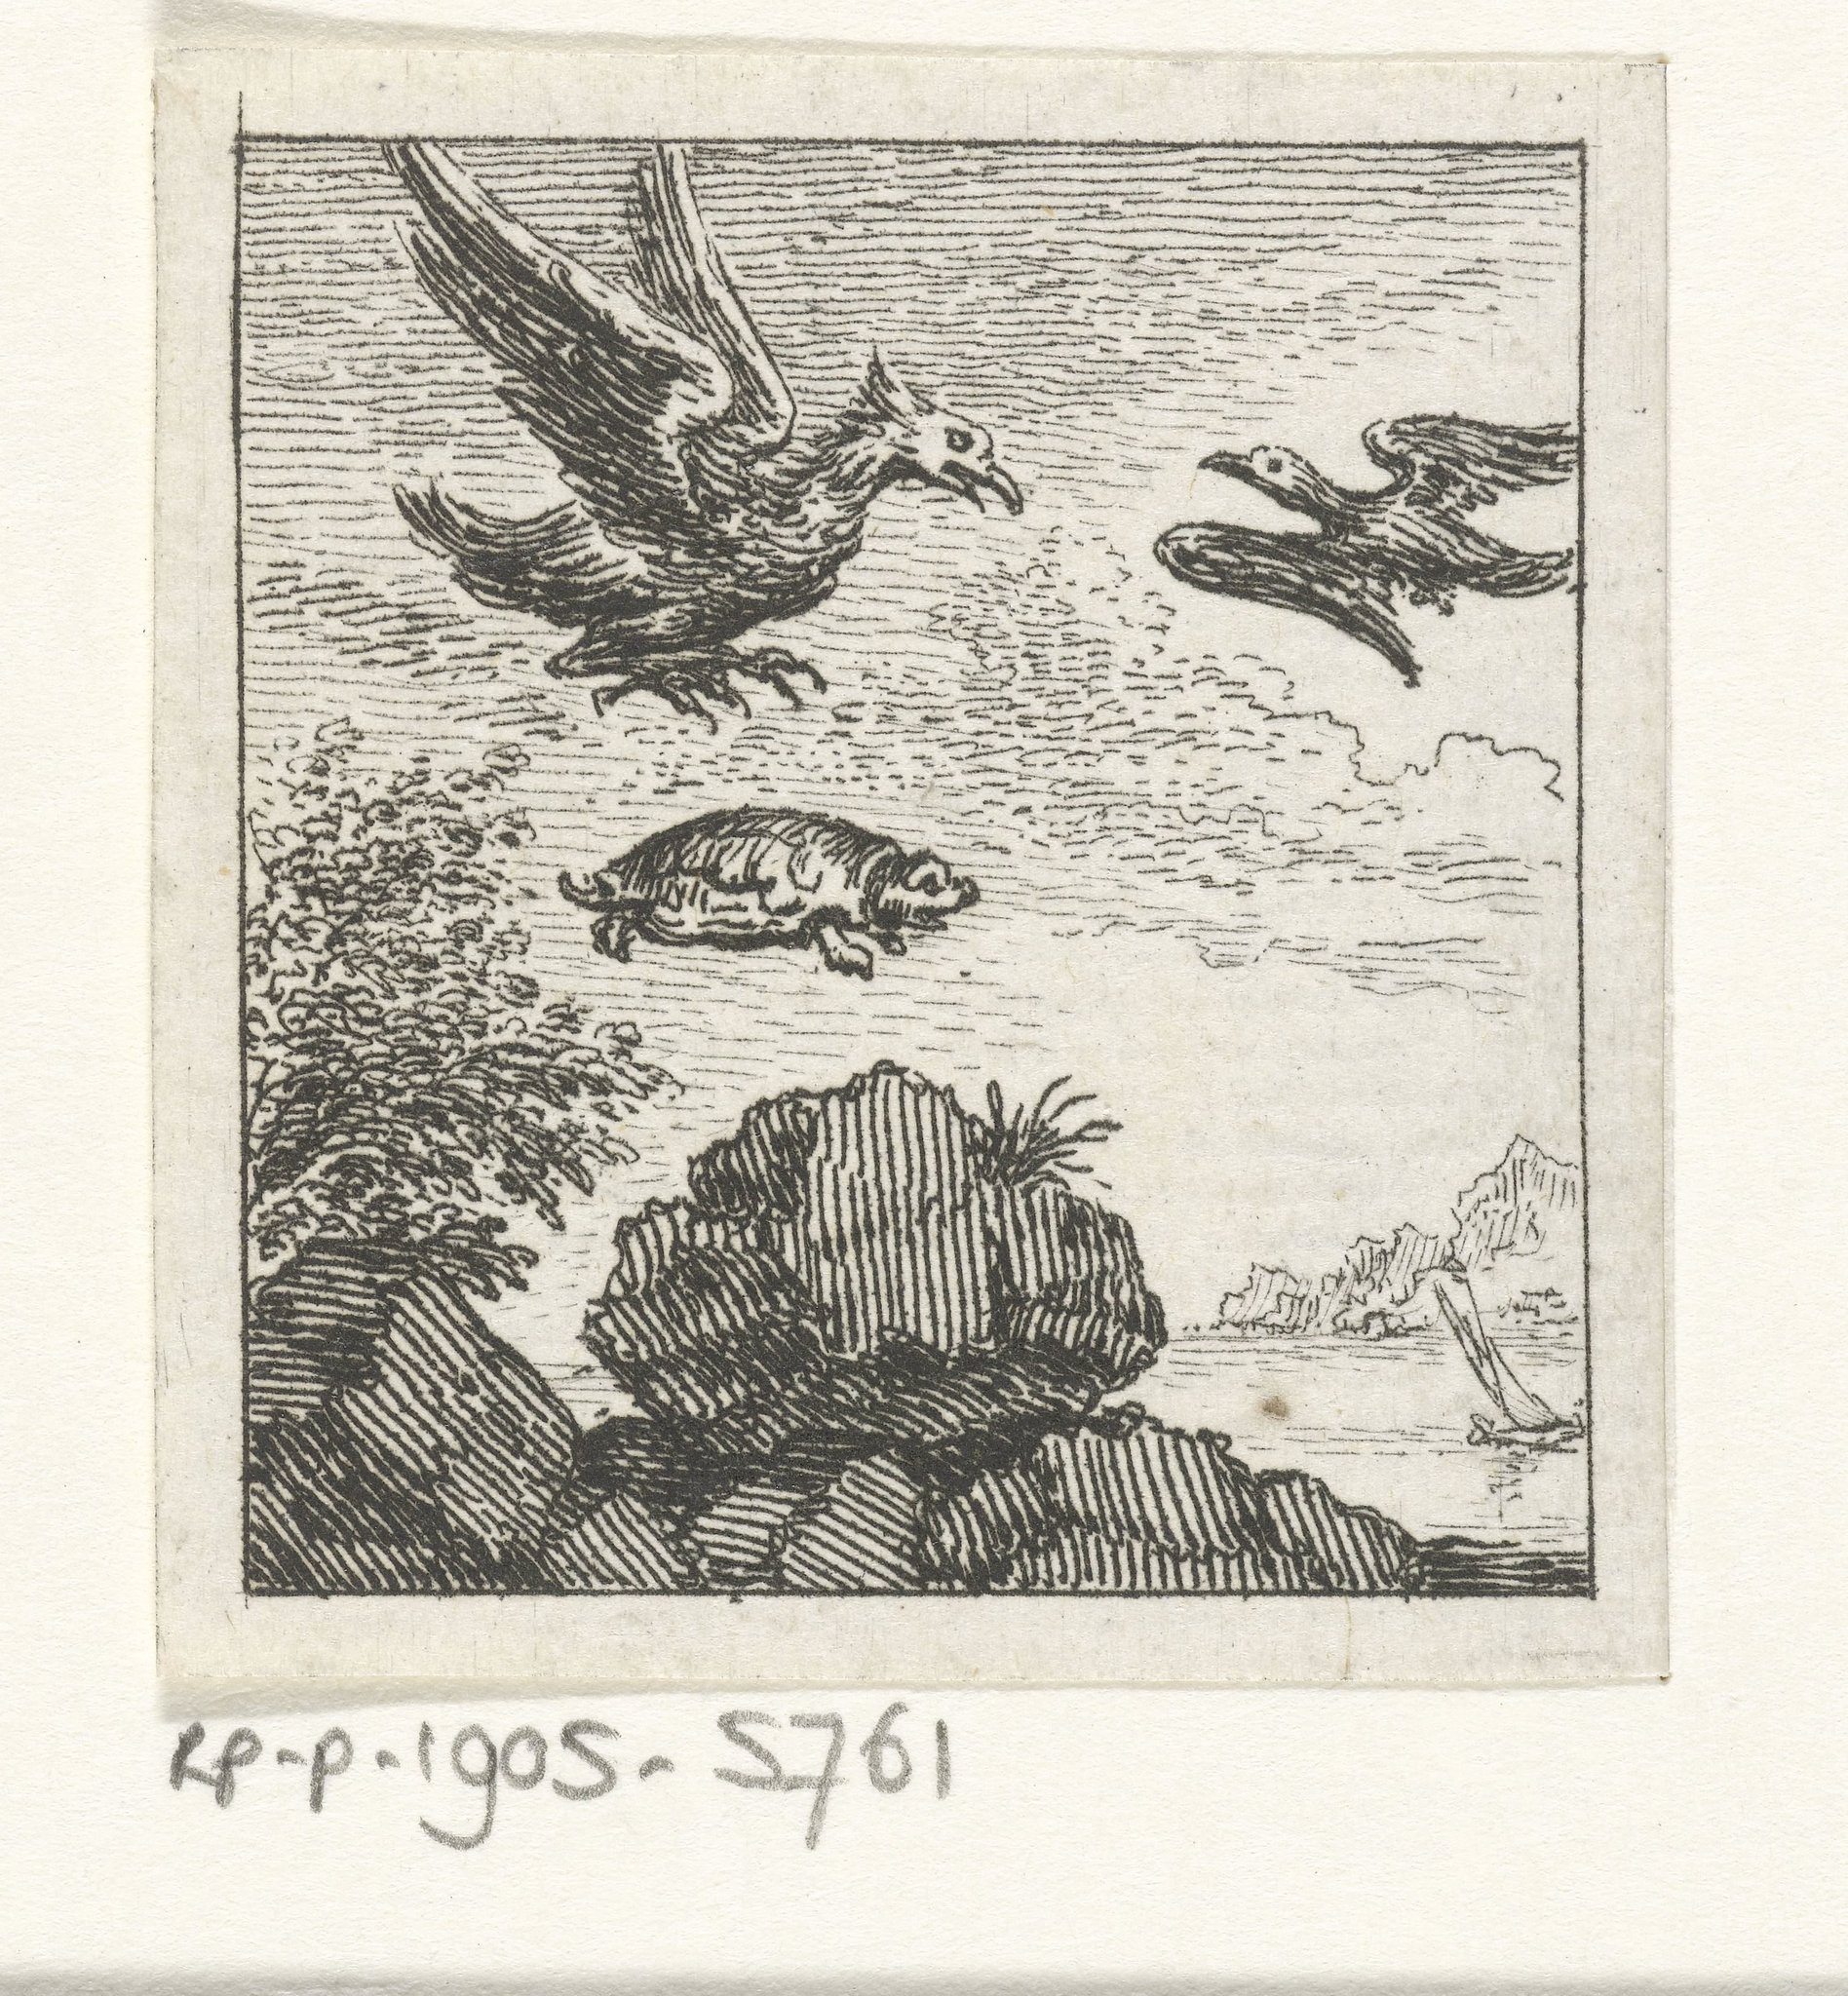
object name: print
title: Illustraties voor fabelvertellingen van Phaedrus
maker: simon fokke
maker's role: draughtsman, print maker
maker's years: 1712-1784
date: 1769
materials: paper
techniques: etching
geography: amsterdam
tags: fables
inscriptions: collector's mark: Lugt 2228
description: Een arend laat, al vliegend naast een kraai, een schildpad uit zijn klauwen op een rots vallen. Deze illustratie is vervaardigd bij de Aesopische fabels van de Latijnse dichter Phaedrus.